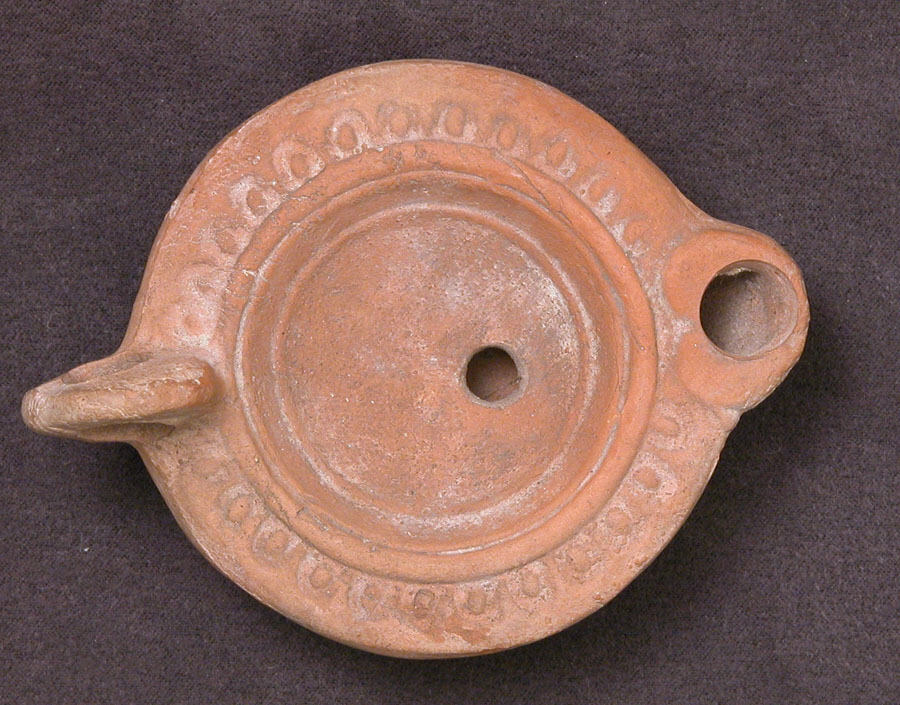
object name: lamp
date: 101-600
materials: earthenware